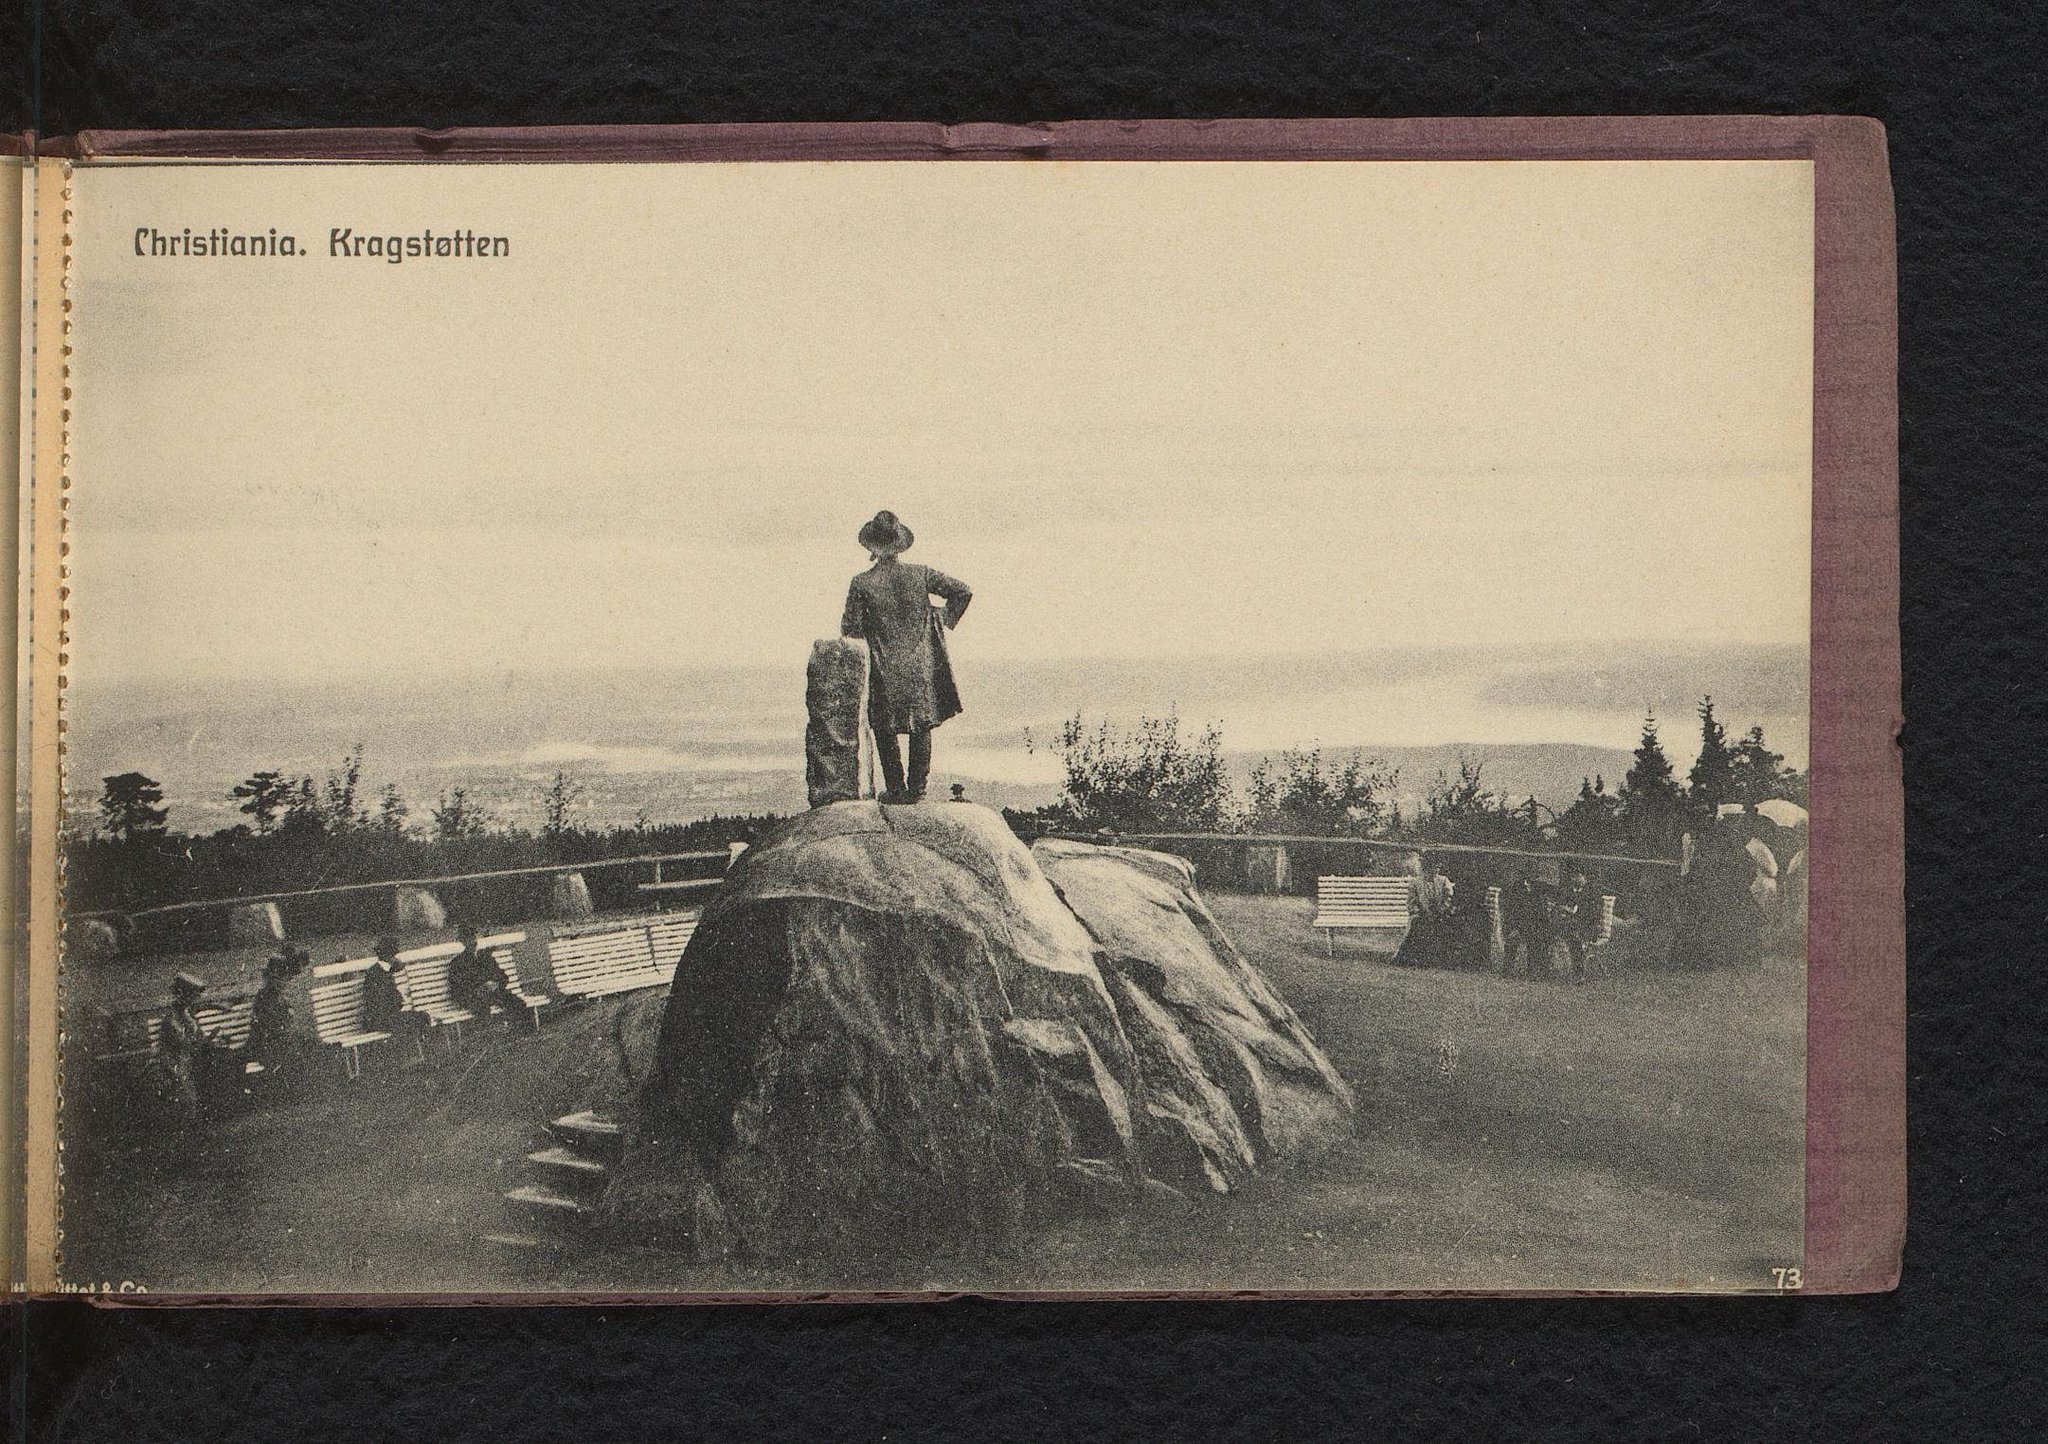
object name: ansichtkaart, prentbriefkaart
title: Christiania. Kragstøtten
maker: Anonymous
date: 1904-1925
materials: cardboard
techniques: photograph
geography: oslo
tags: monument, statue, prospect of city, town panorama, silhouette of city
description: Prentbriefkaart maakt deel uit van een album.